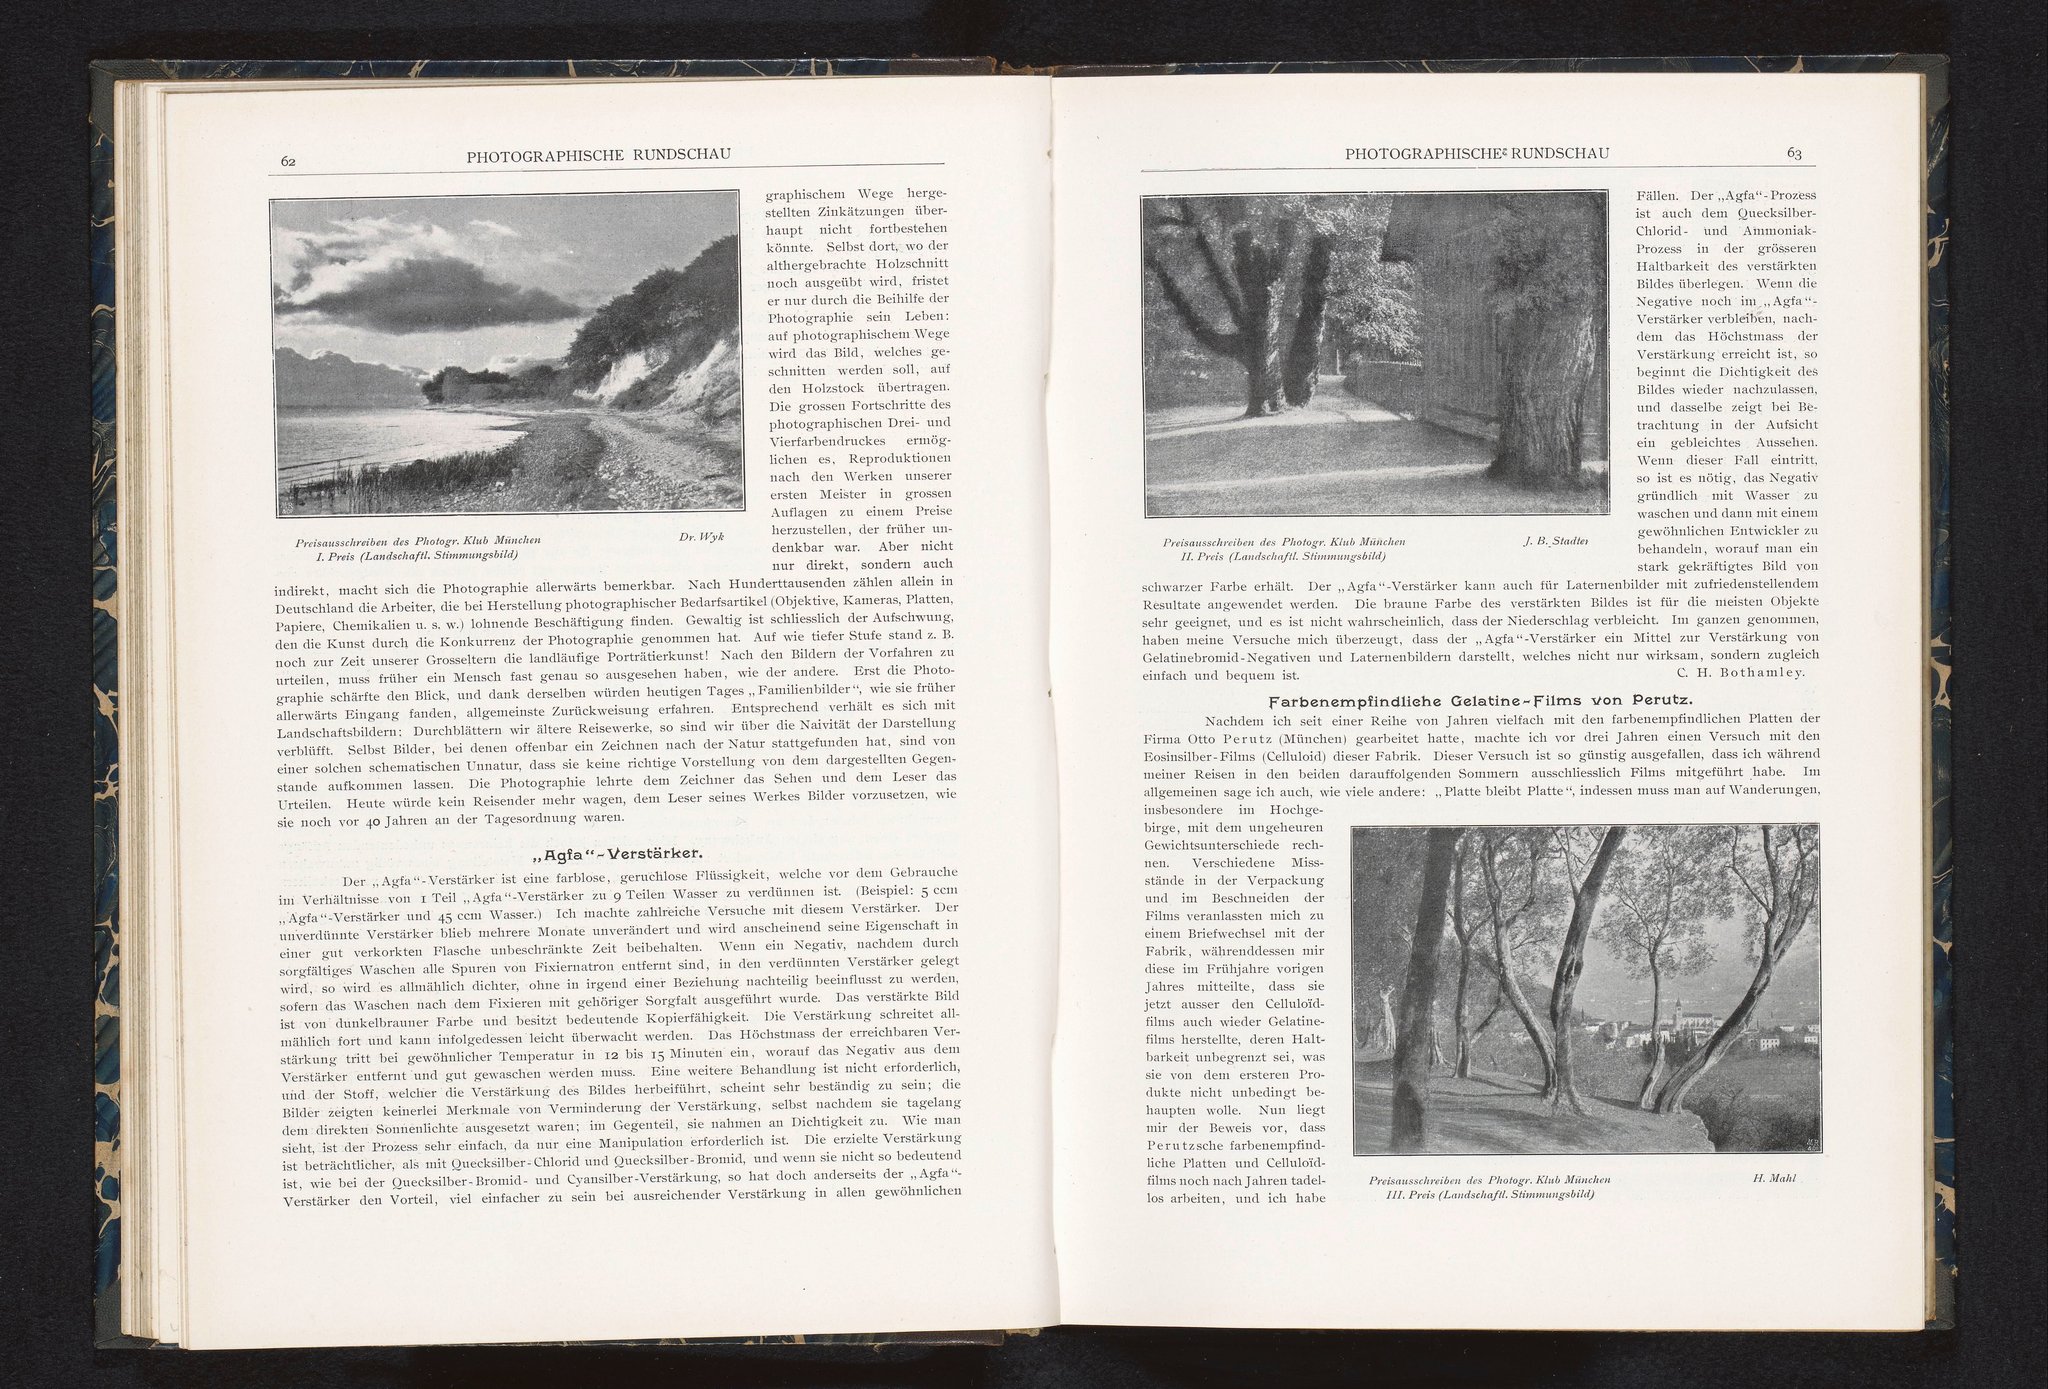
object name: photomechanical print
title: Preisausschreiben des Photogr. Klub München/ II. Preis (Landschaftl. Stimmungsbild)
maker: j.b. stadter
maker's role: fotograaf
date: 1896-1901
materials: paper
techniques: autotype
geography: berlin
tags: trees, civic architecture; edifices; dwellings